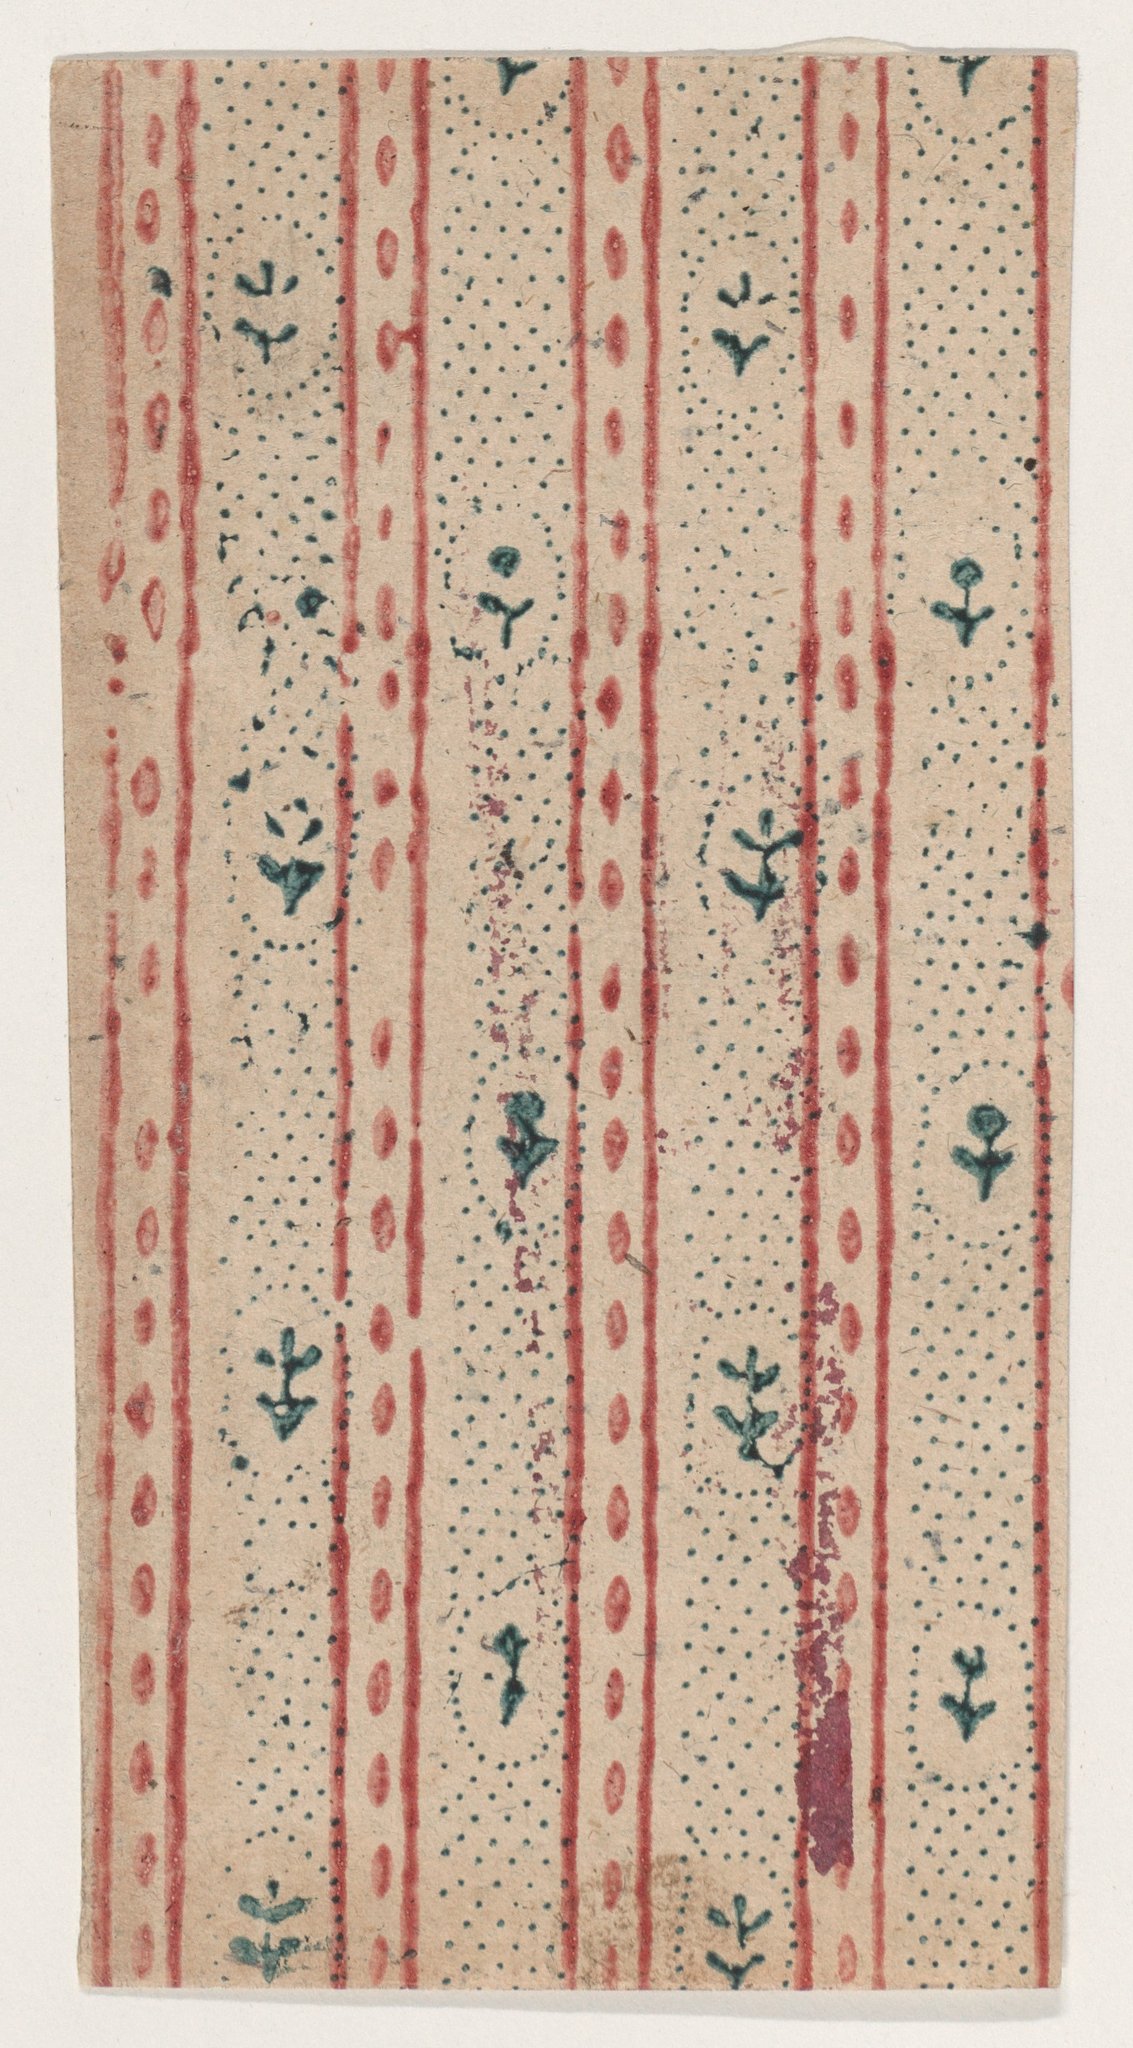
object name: print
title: Sheet with overall stripe and dot pattern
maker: Anonymous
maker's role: artist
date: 1801-1900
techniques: relief print